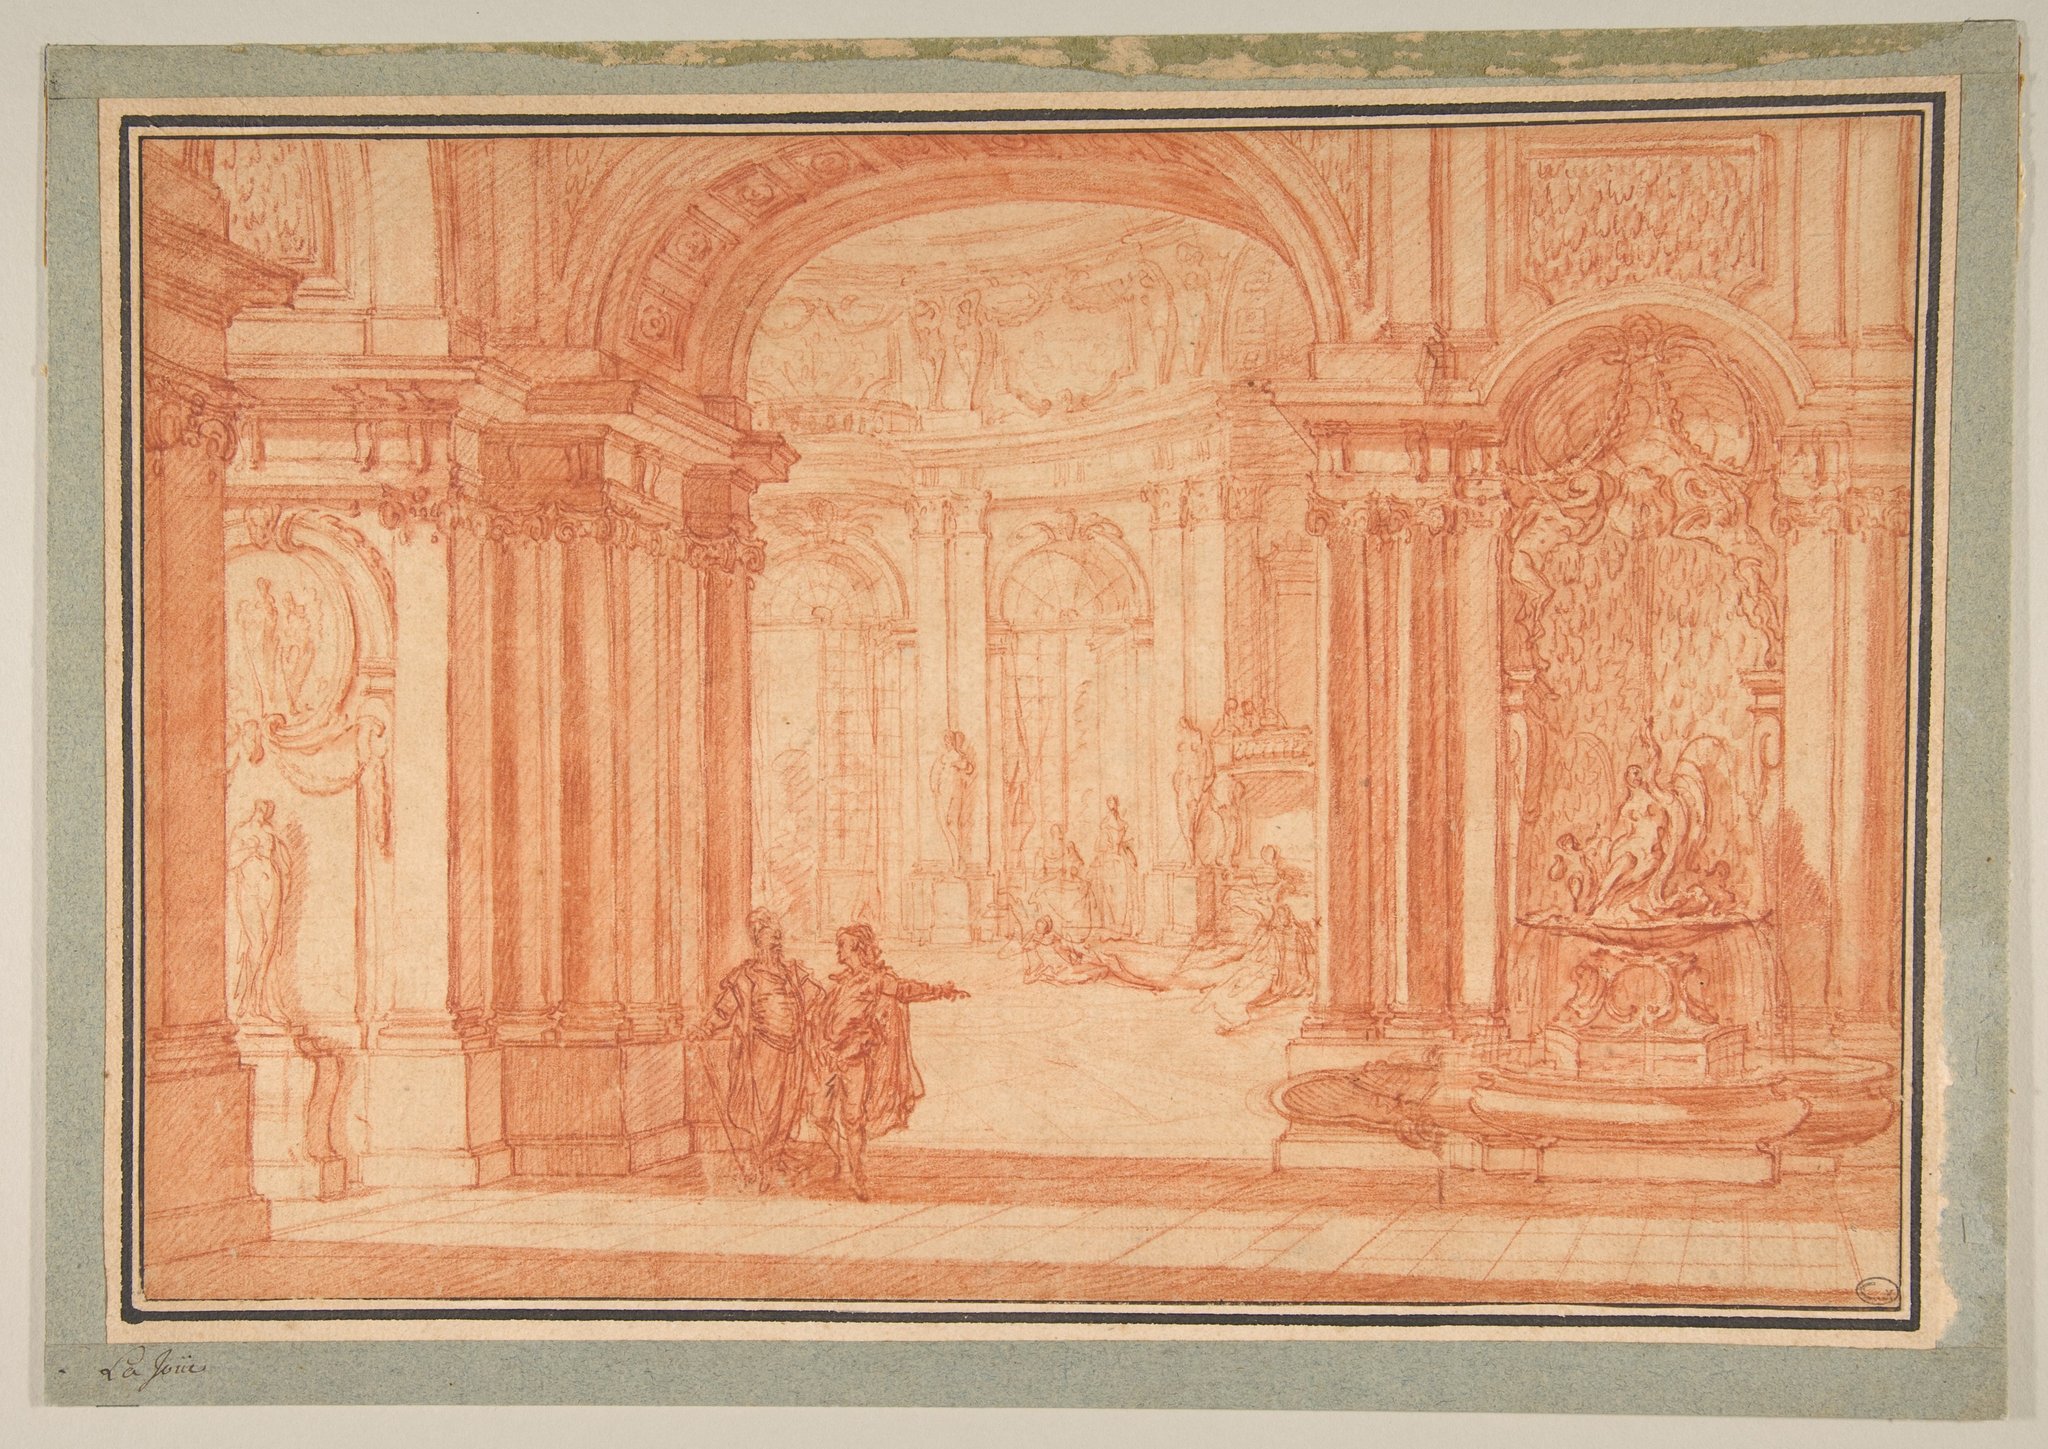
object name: drawing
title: Study for the Rotunda of a Palace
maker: jacques de lajoüe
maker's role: artist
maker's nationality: french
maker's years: 1686-1761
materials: chalk, ink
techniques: pen, wash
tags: architecture,palaces